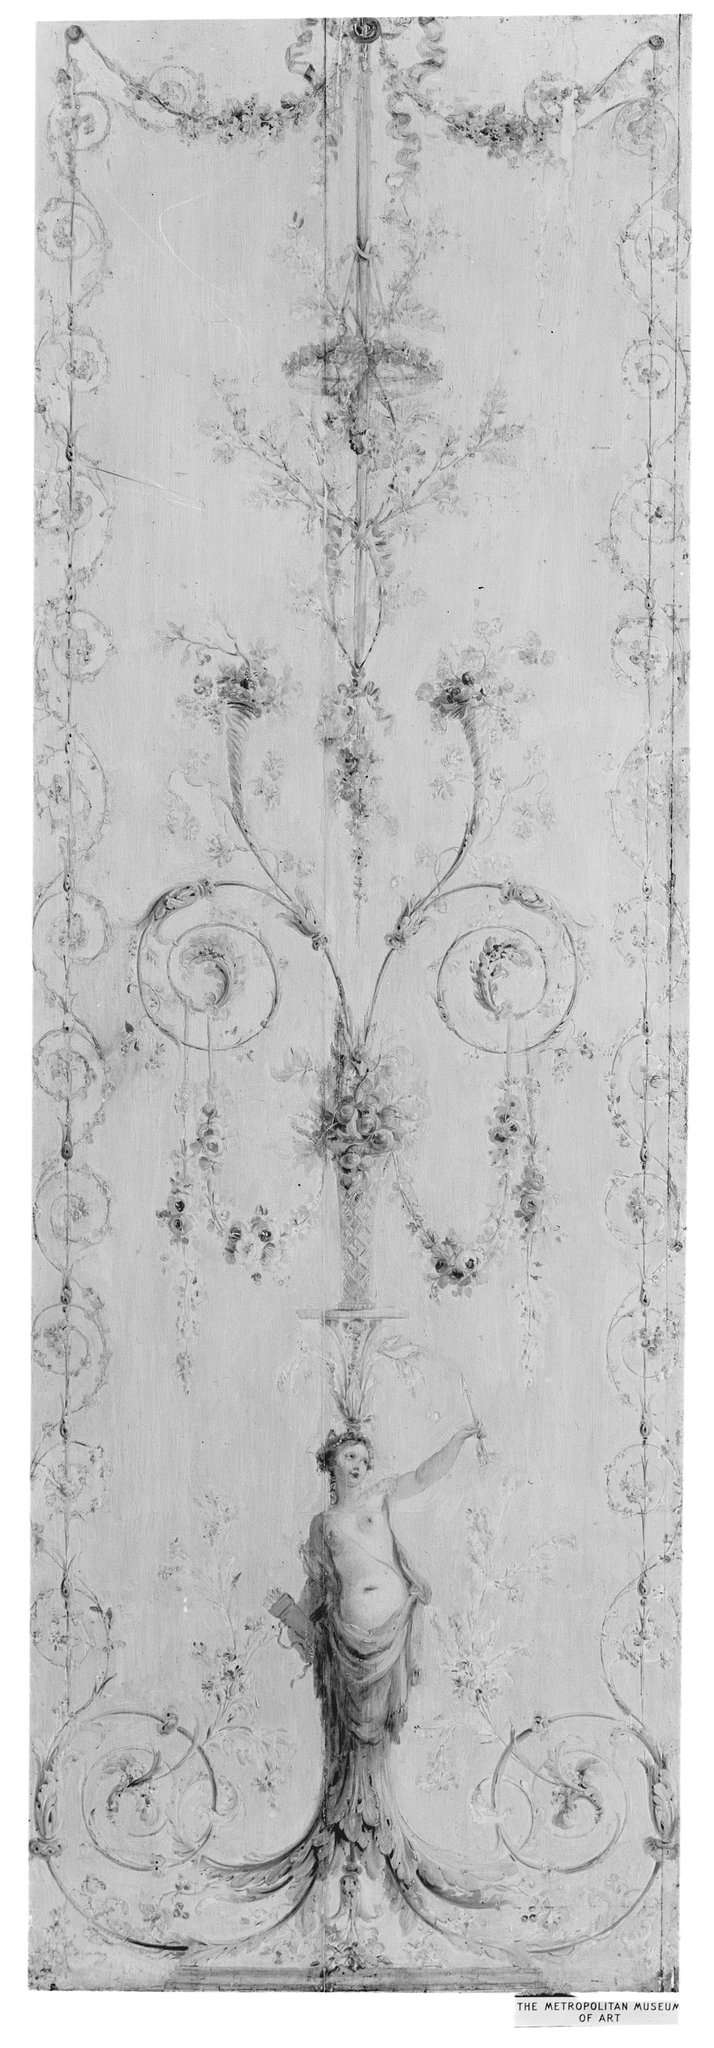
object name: door panel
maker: jean-baptiste huet i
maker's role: artist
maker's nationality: french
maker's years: 1745-1811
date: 1770-1790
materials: wood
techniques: painting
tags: female nudes